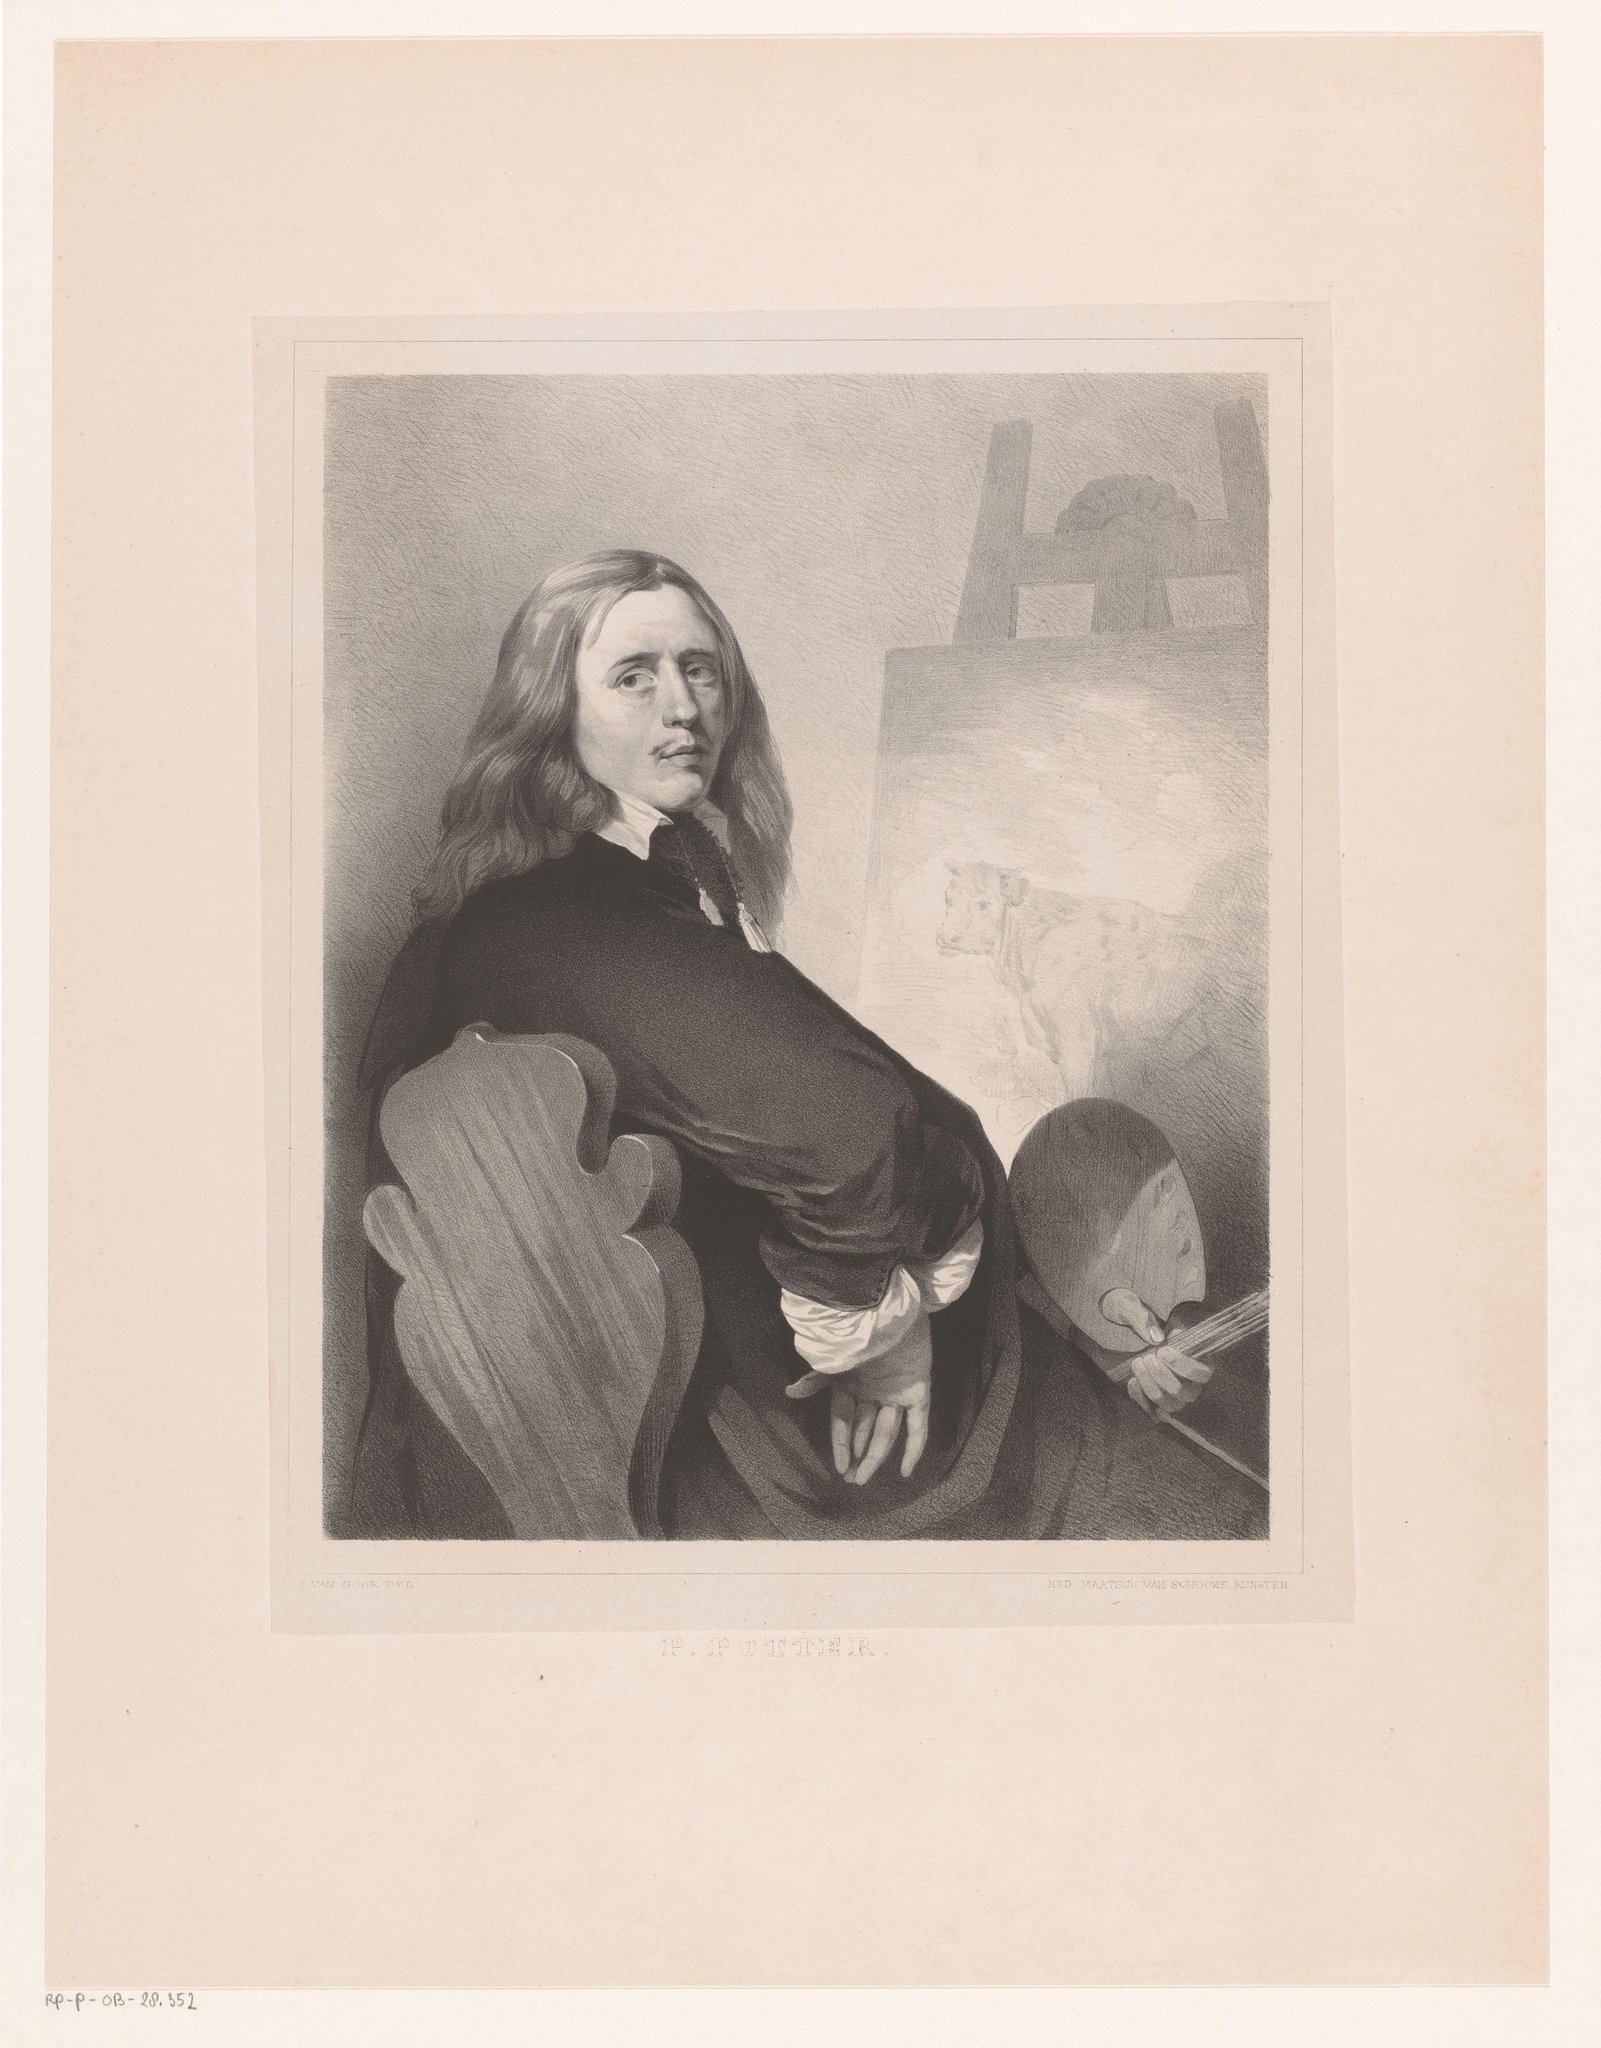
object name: print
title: Portret van Paulus Potter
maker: f. van goor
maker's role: print maker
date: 1840-1843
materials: paper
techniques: lithograph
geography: the hague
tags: enkhuizen, amsterdam, painter, print maker, draughtsman, paulus potter, easel (+ artist at work), historical persons (+ (full) bust portrait)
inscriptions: collector's mark: Lugt 2228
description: De geportretteerde zit achter zijn schildersezel. Daarop staat een schilderij met een koe. Hij heeft een palet en kwasten in zijn linkerhand en kijkt achterom.